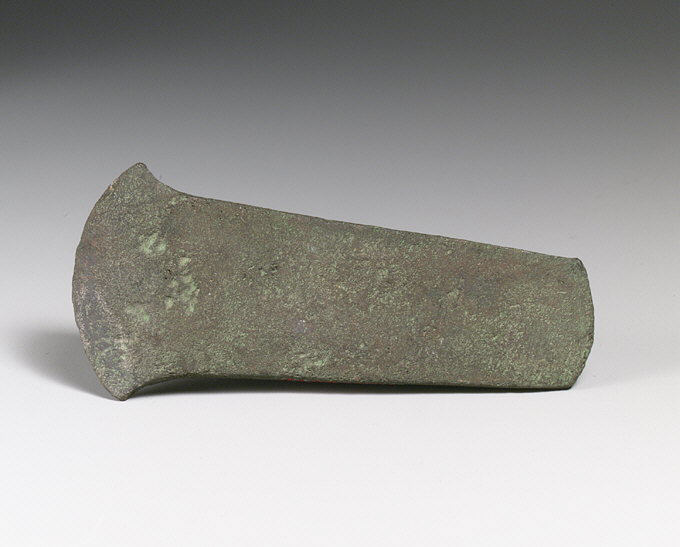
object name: axehead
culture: cypriot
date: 3200-2000 BCE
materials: bronze